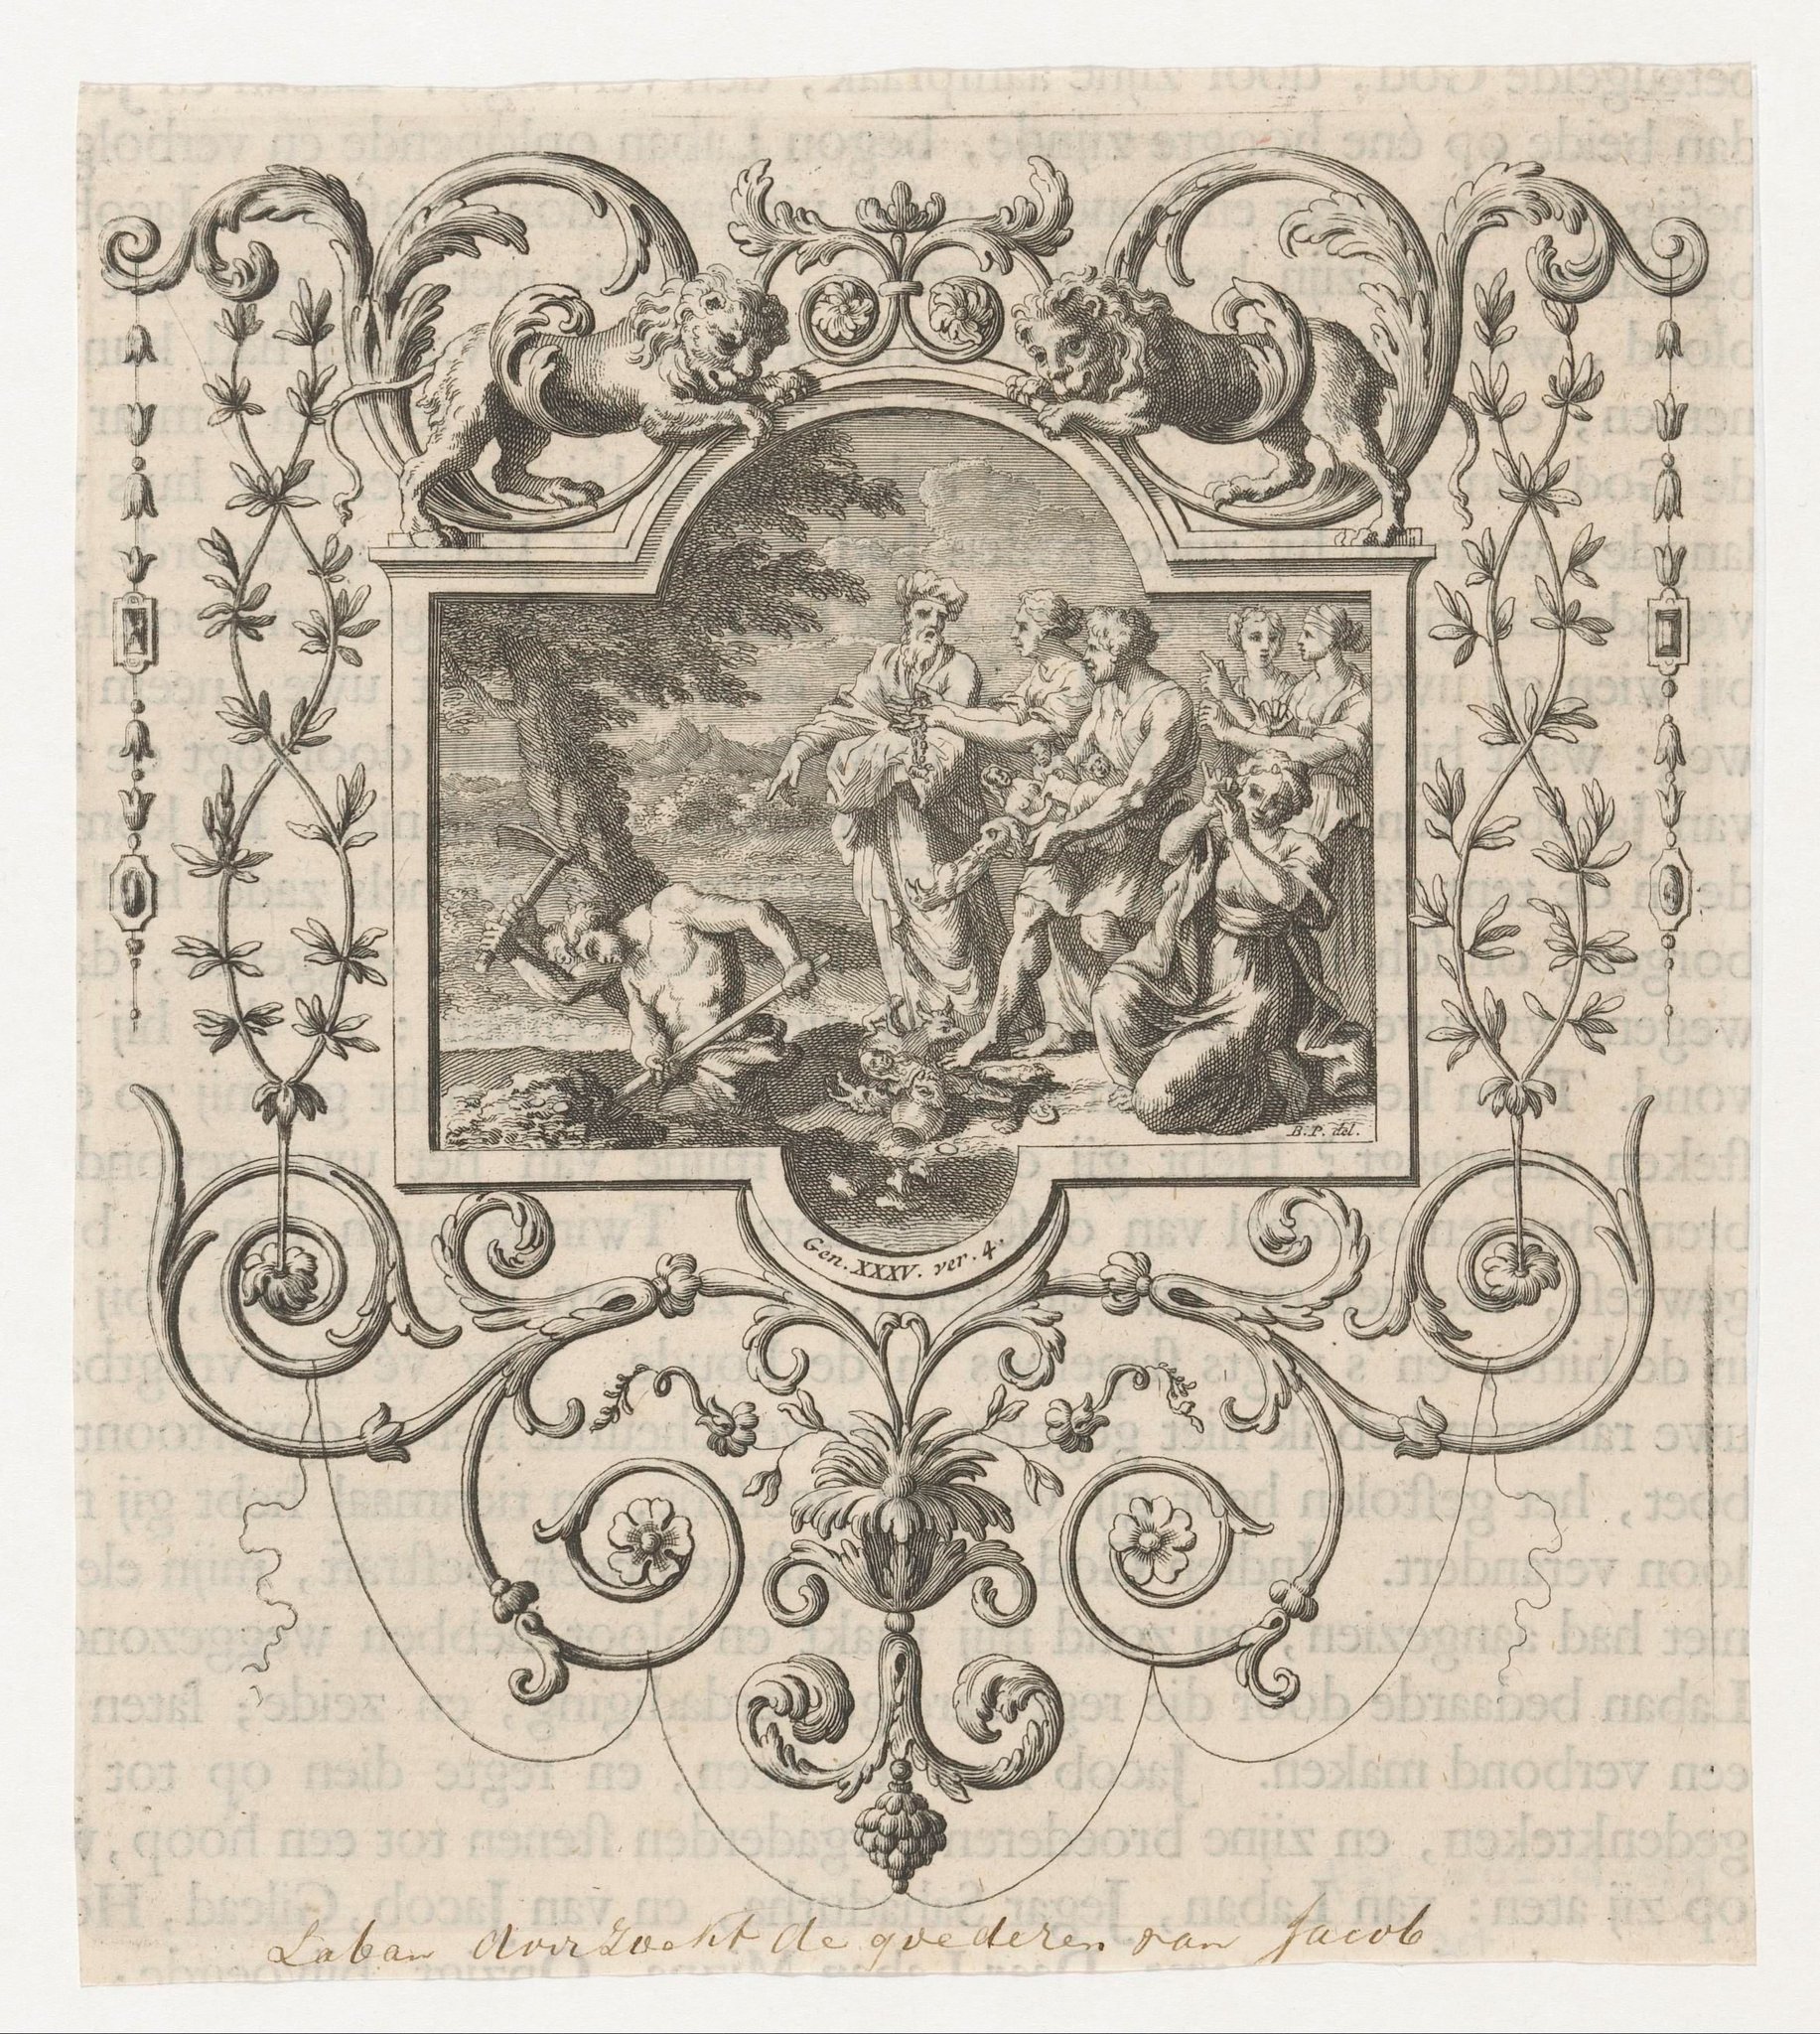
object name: ornament print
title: Jakob begraaft de afgodsbeelden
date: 1683-1733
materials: paper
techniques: engraving, etching, letterpress printing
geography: amsterdam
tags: the idols (and ear-rings) are hidden under an oak at shechem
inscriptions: inscription: ‘Laban doorzoekt de goederen van Jacob’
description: Prent oorspronkelijk bedoeld voor: Figures de la Bible. Amsterdam, Bernard Picart, 1720. Prent tevens oorspronkelijk bedoeld voor: Taferelen der voornaamste geschiedenissen van het Oude en Nieuwe Testament (...) door de vermaarde kunstenaars Hoet, Houbraken, en Picart getekent (...) en met beschrijvingen uitgebreid. Den Haag: Pieter de Hondt, 1728. Prent kan mogelijk ook zijn gebruikt in andere bijbels.